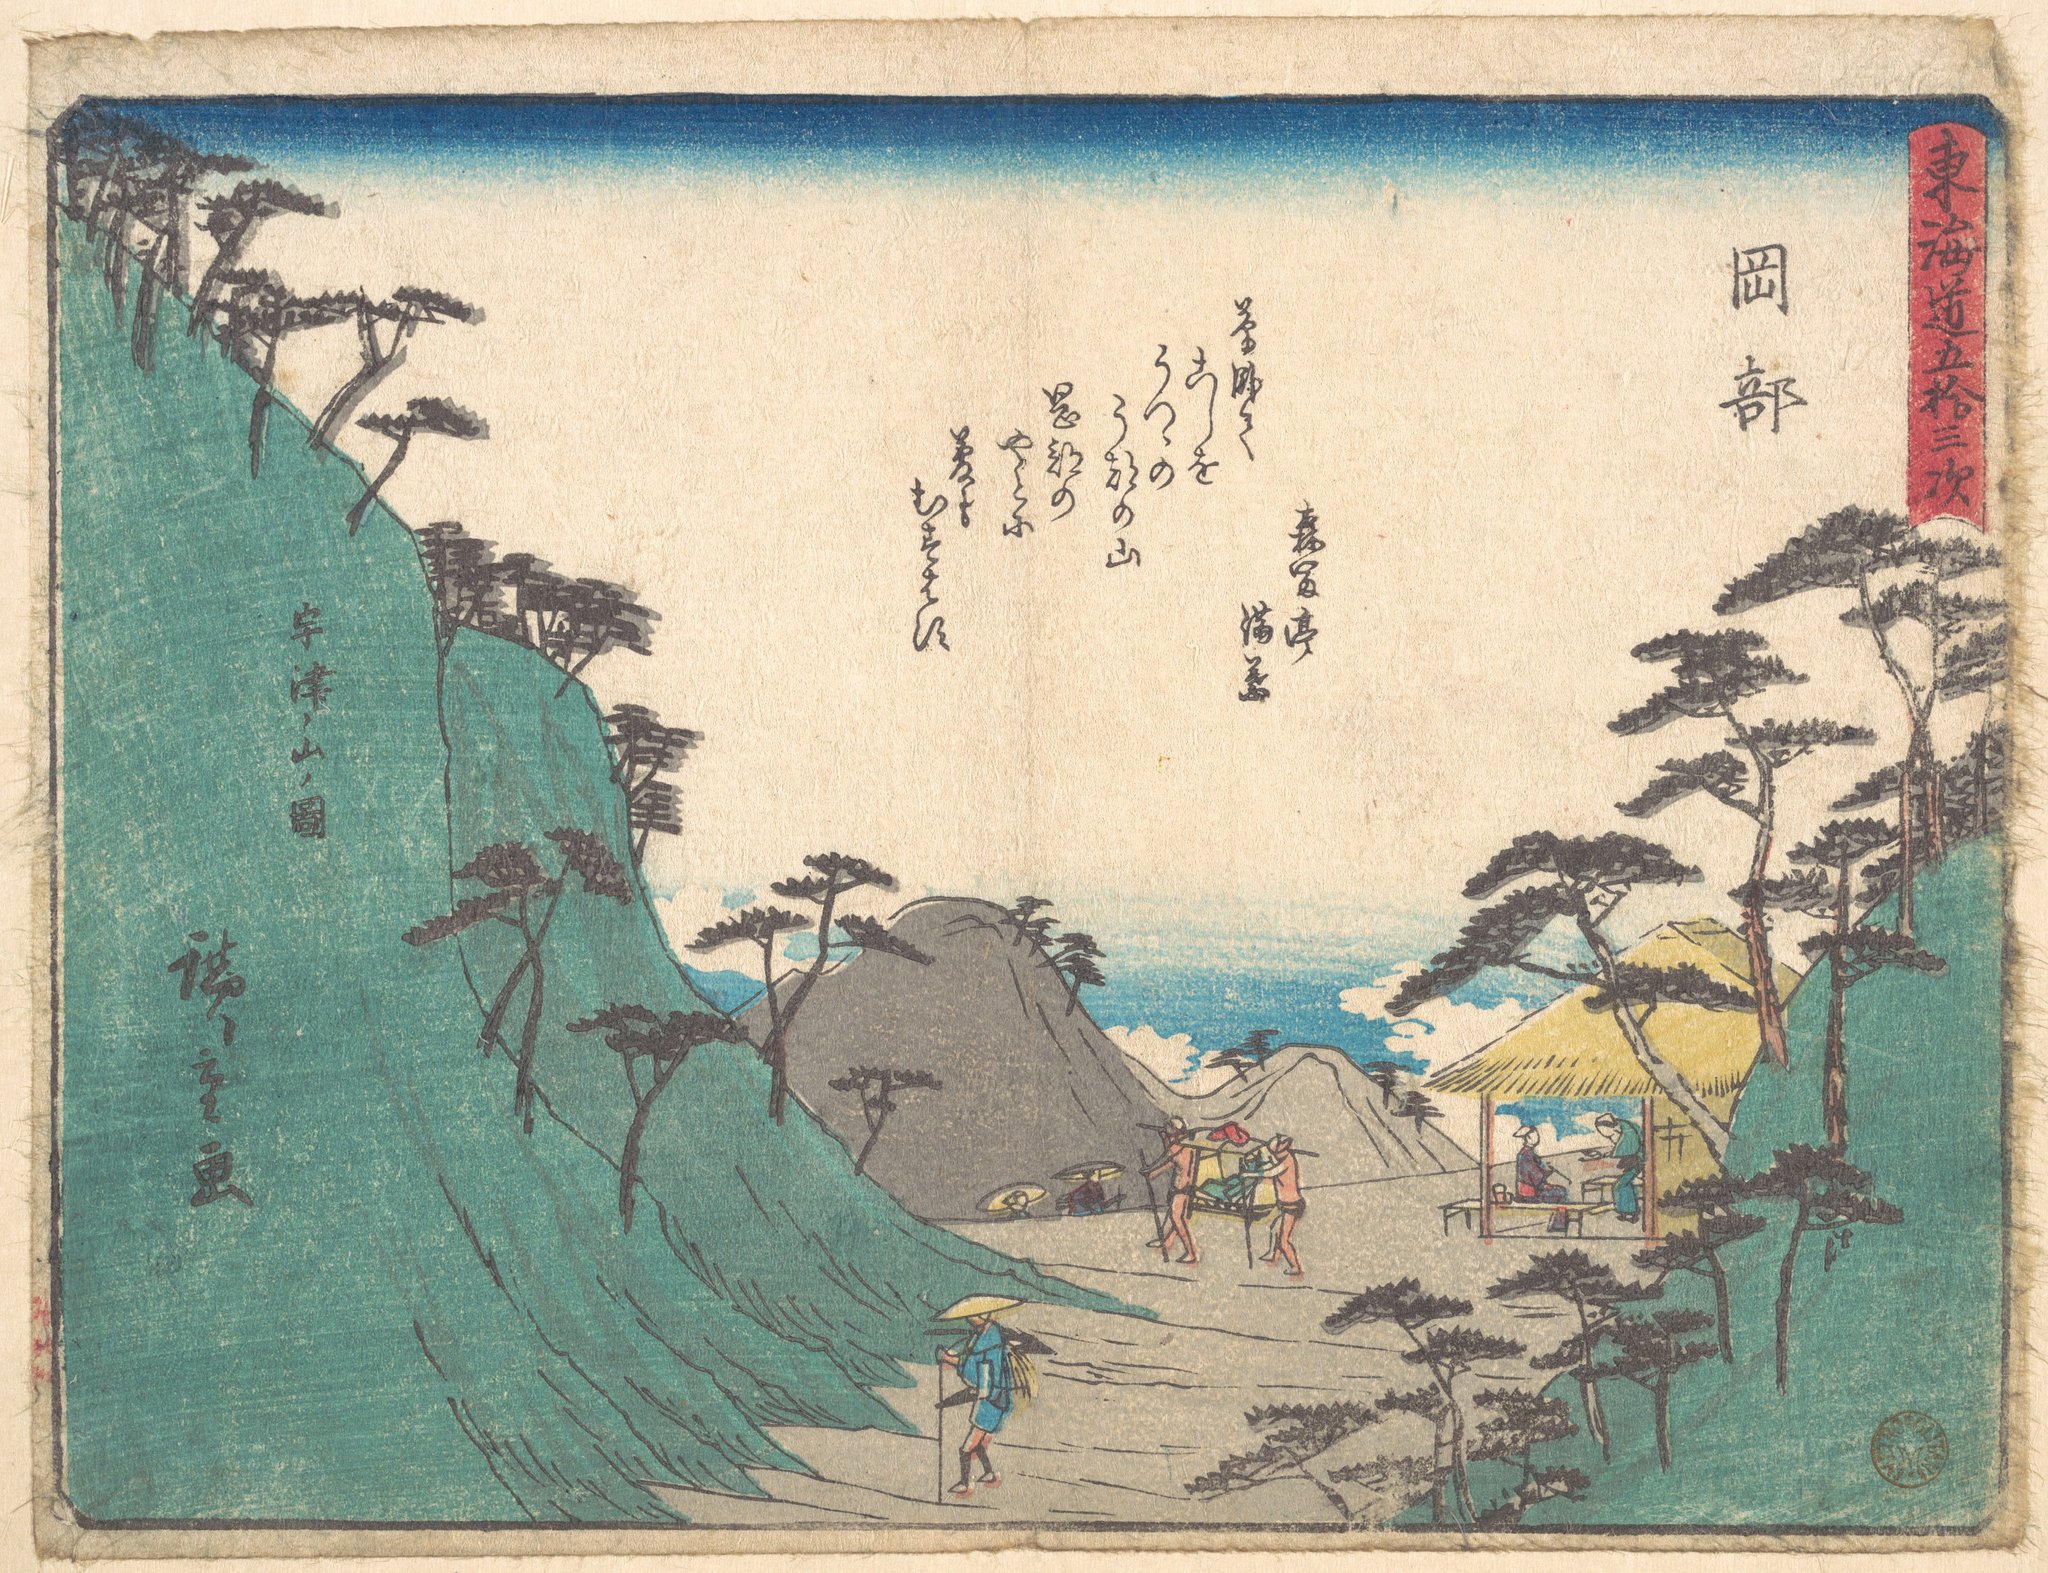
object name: print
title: Okabe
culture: japanese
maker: utagawa hiroshige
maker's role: artist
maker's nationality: japanese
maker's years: 1797-1858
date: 1838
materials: ink, paper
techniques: woodblock print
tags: houses,men,hills,trees